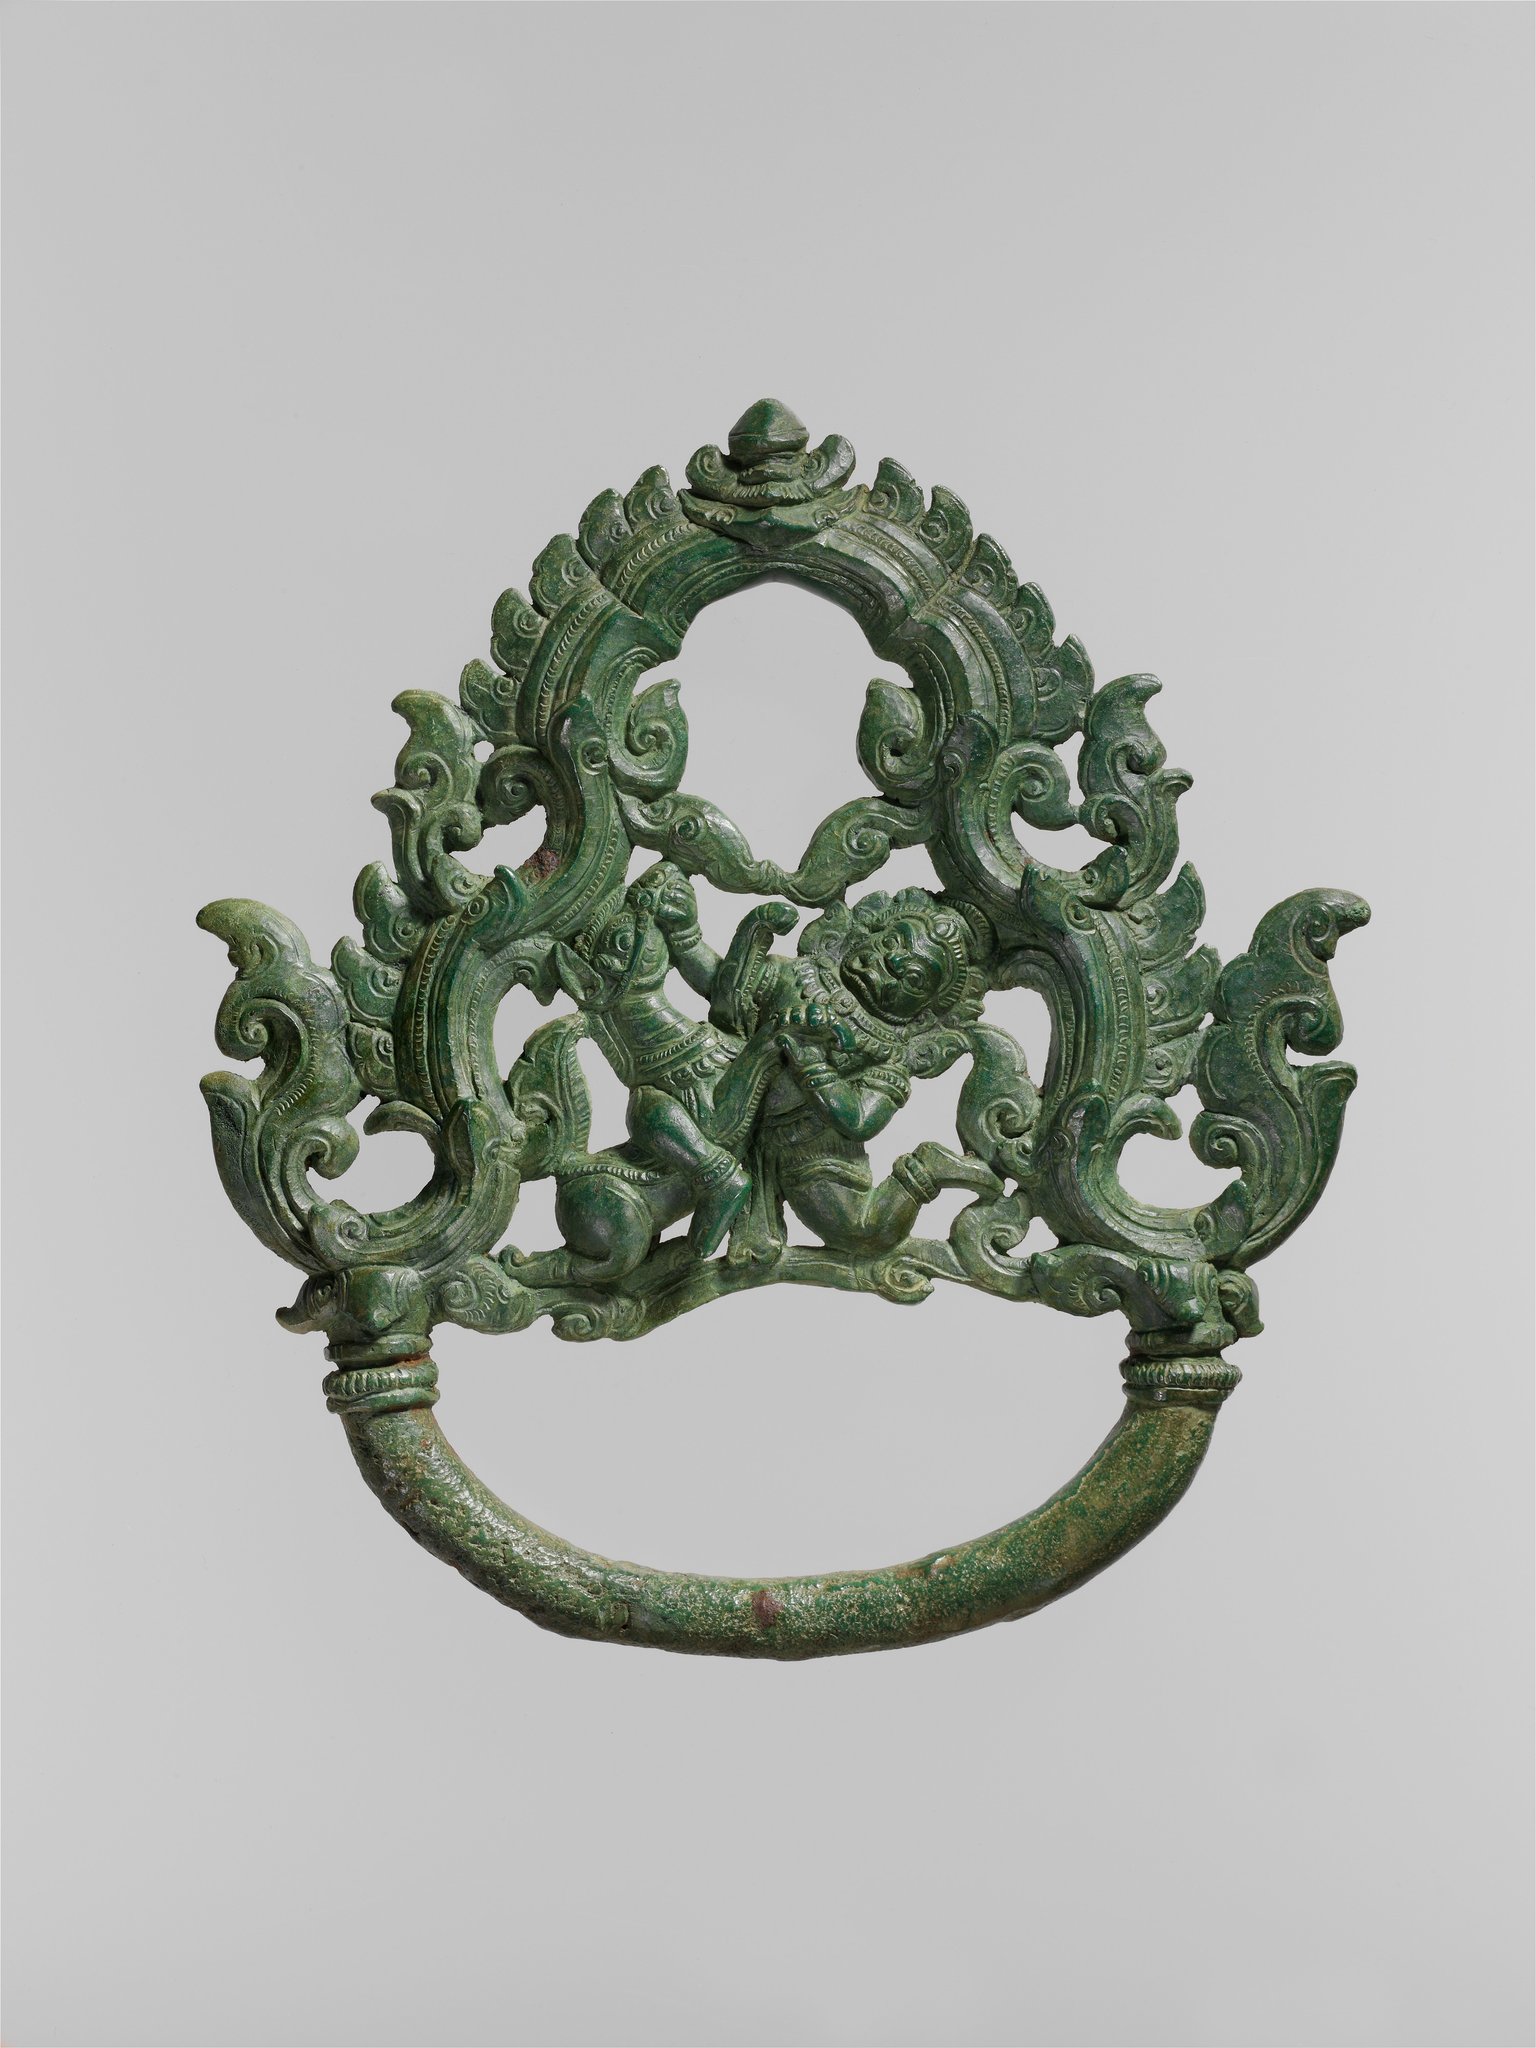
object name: palanquin ring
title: Palanquin Ring with Demon Battling a Horse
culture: cambodian or thai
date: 1201-1233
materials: bronze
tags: horses,demons